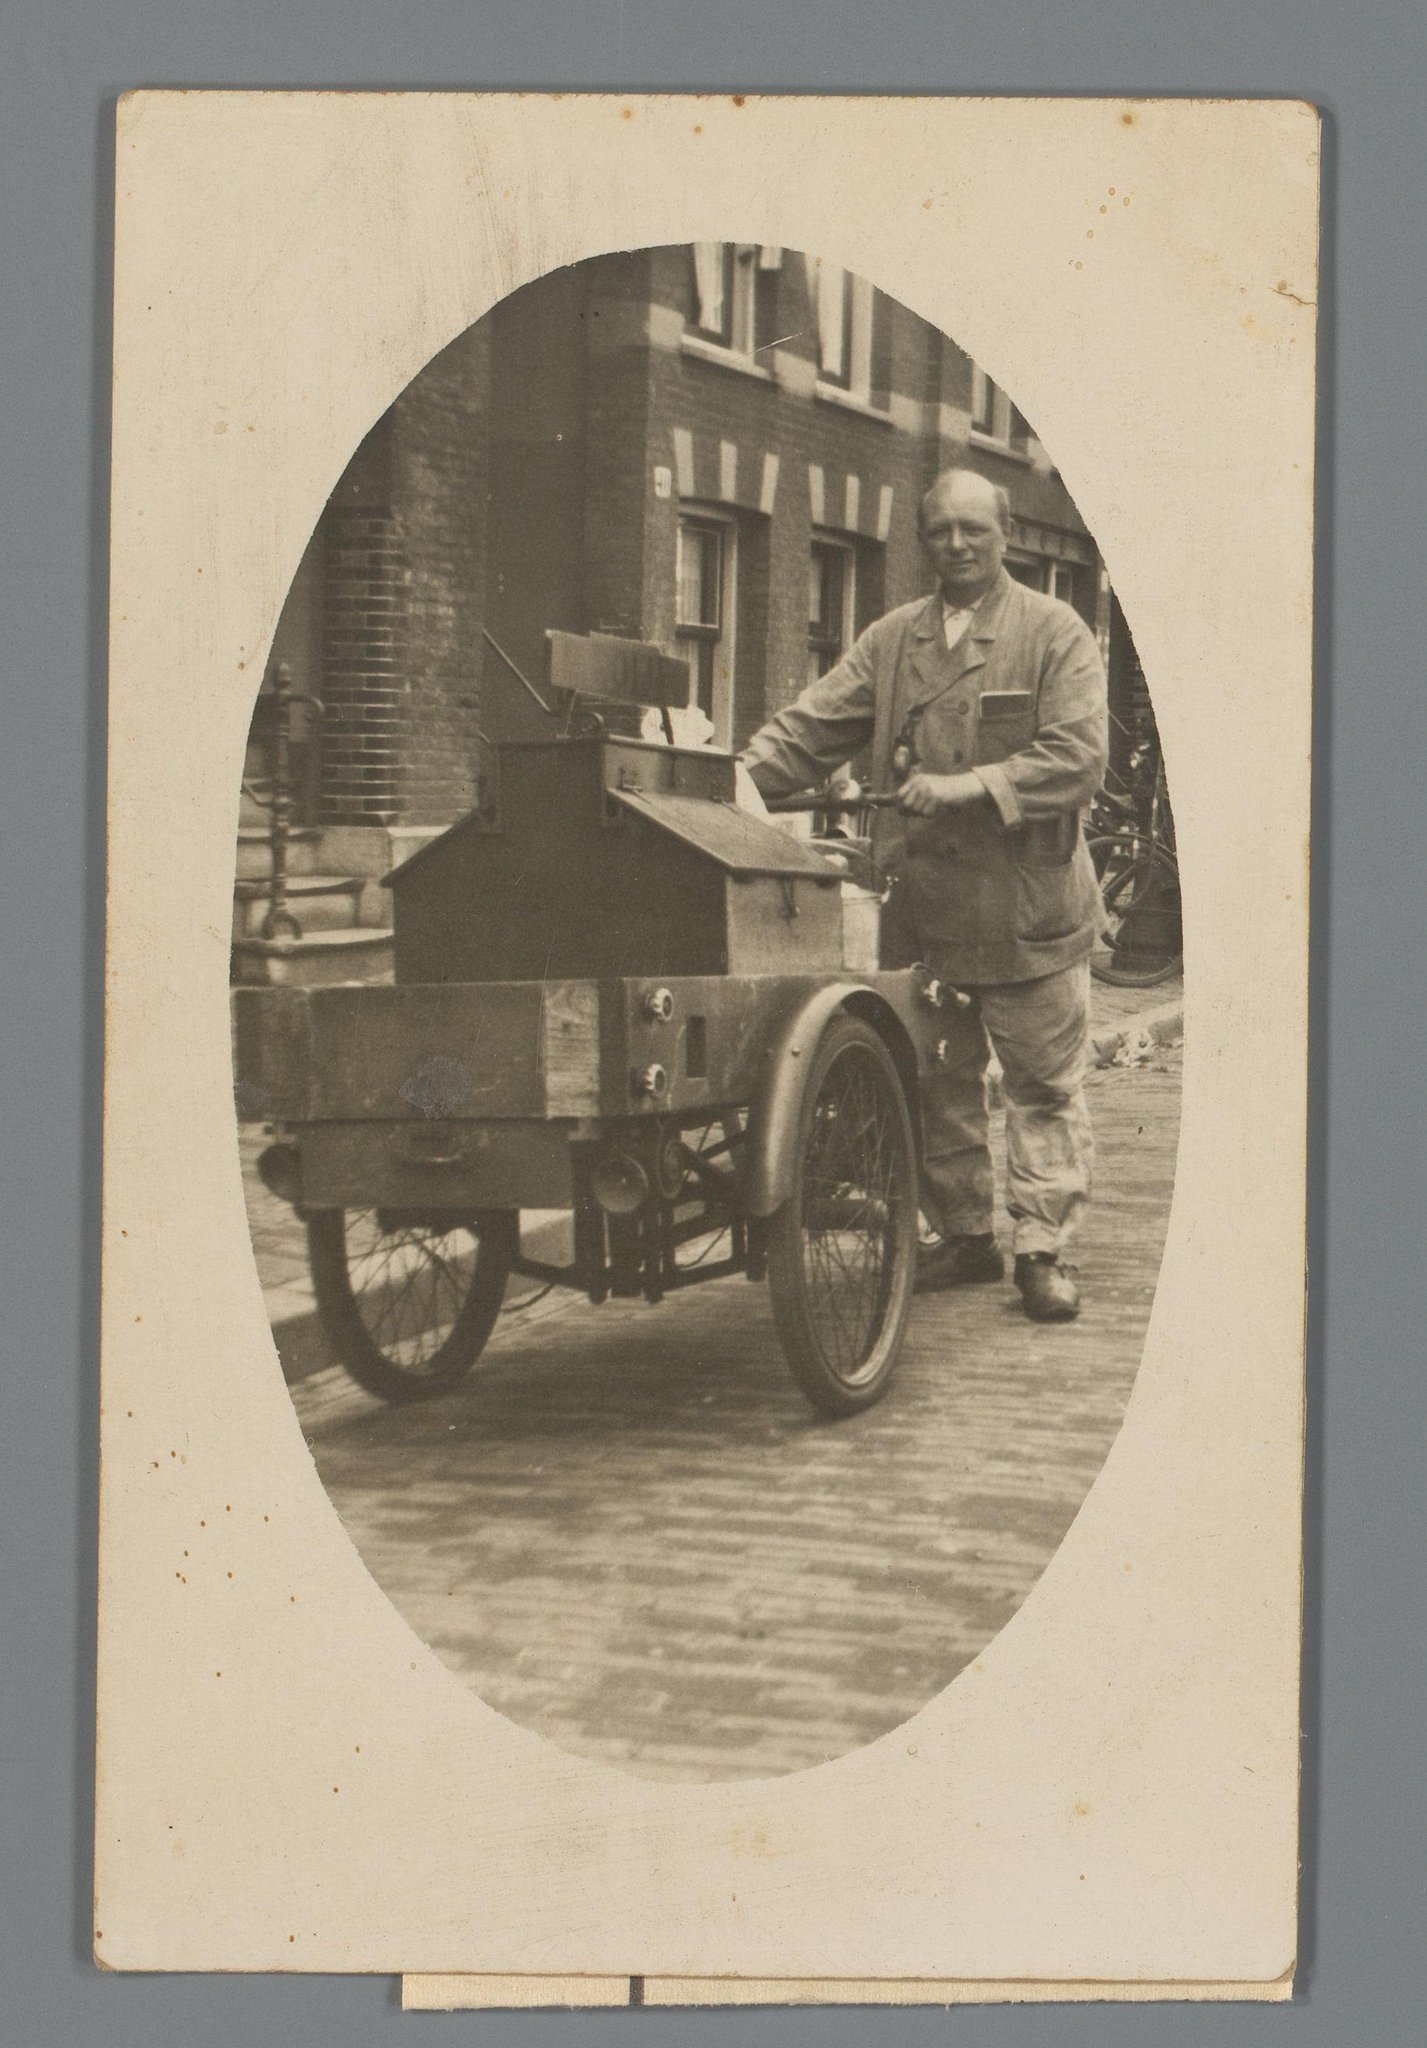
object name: photograph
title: Portret van een onbekende melkboer bij zijn bakfiets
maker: Anonymous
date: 1950-1969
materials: paper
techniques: gelatin silver print, letterpress printing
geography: amsterdam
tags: carrier-tricycle, anonymous historical person portrayed, transportation of milk, amsterdam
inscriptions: inscription: ‘De Telegraaf/ (...) 13 februari 1969/ Arrestatie/ in moord-/ zaak van/ A'damse/ melkboer (...)’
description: Aan de foto zit een krantenbericht geplakt uit 1969 waarin melding wordt gemaakt van een arrestatie in verband met de moord op een Amsterdamse melkboer.